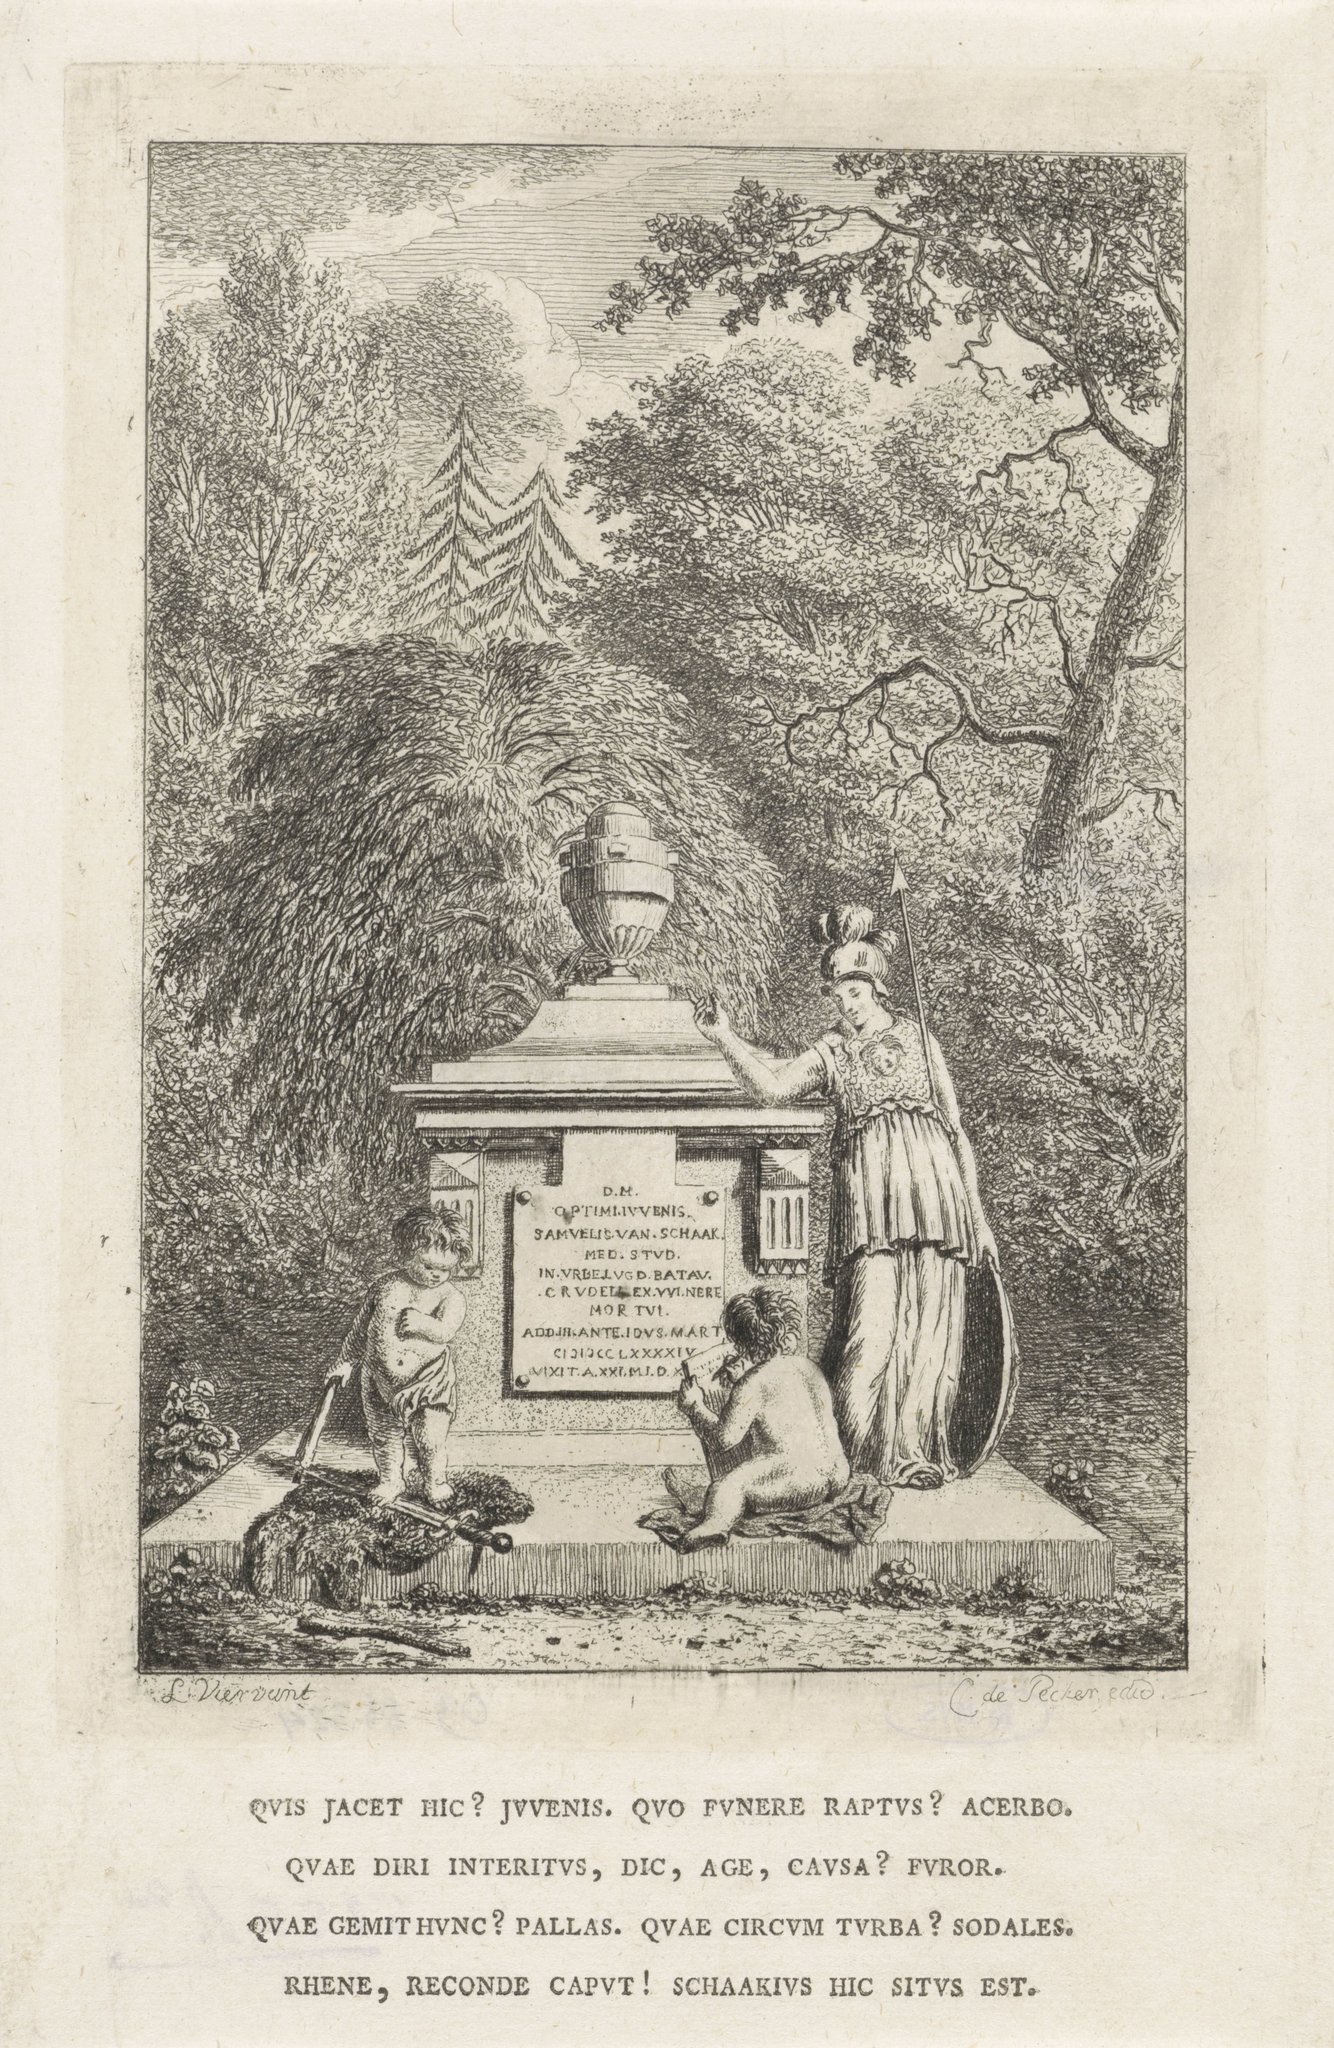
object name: print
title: Allegorisch grafmonument voor de Leidse student S. van Schaak, 1794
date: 1794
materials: paper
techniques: etching, letterpress printing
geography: leiden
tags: leiden, grave-building, monumental tomb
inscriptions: collector's mark: Lugt 2228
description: Allegorisch grafmonument voor de Leidse student in de medicijnen Samuel van Schaak, die op 2 maart in een gevecht met majoor De Graaf van de schutterij gewond raakte en op 11 maart 1794 aan de gevolgen van zijn verwonding overleed. Twee putto en Minerva bij een grafmonument in bosrijke omgeving. Met vierregelig vers in het Latijn op het blad onder de plaat.